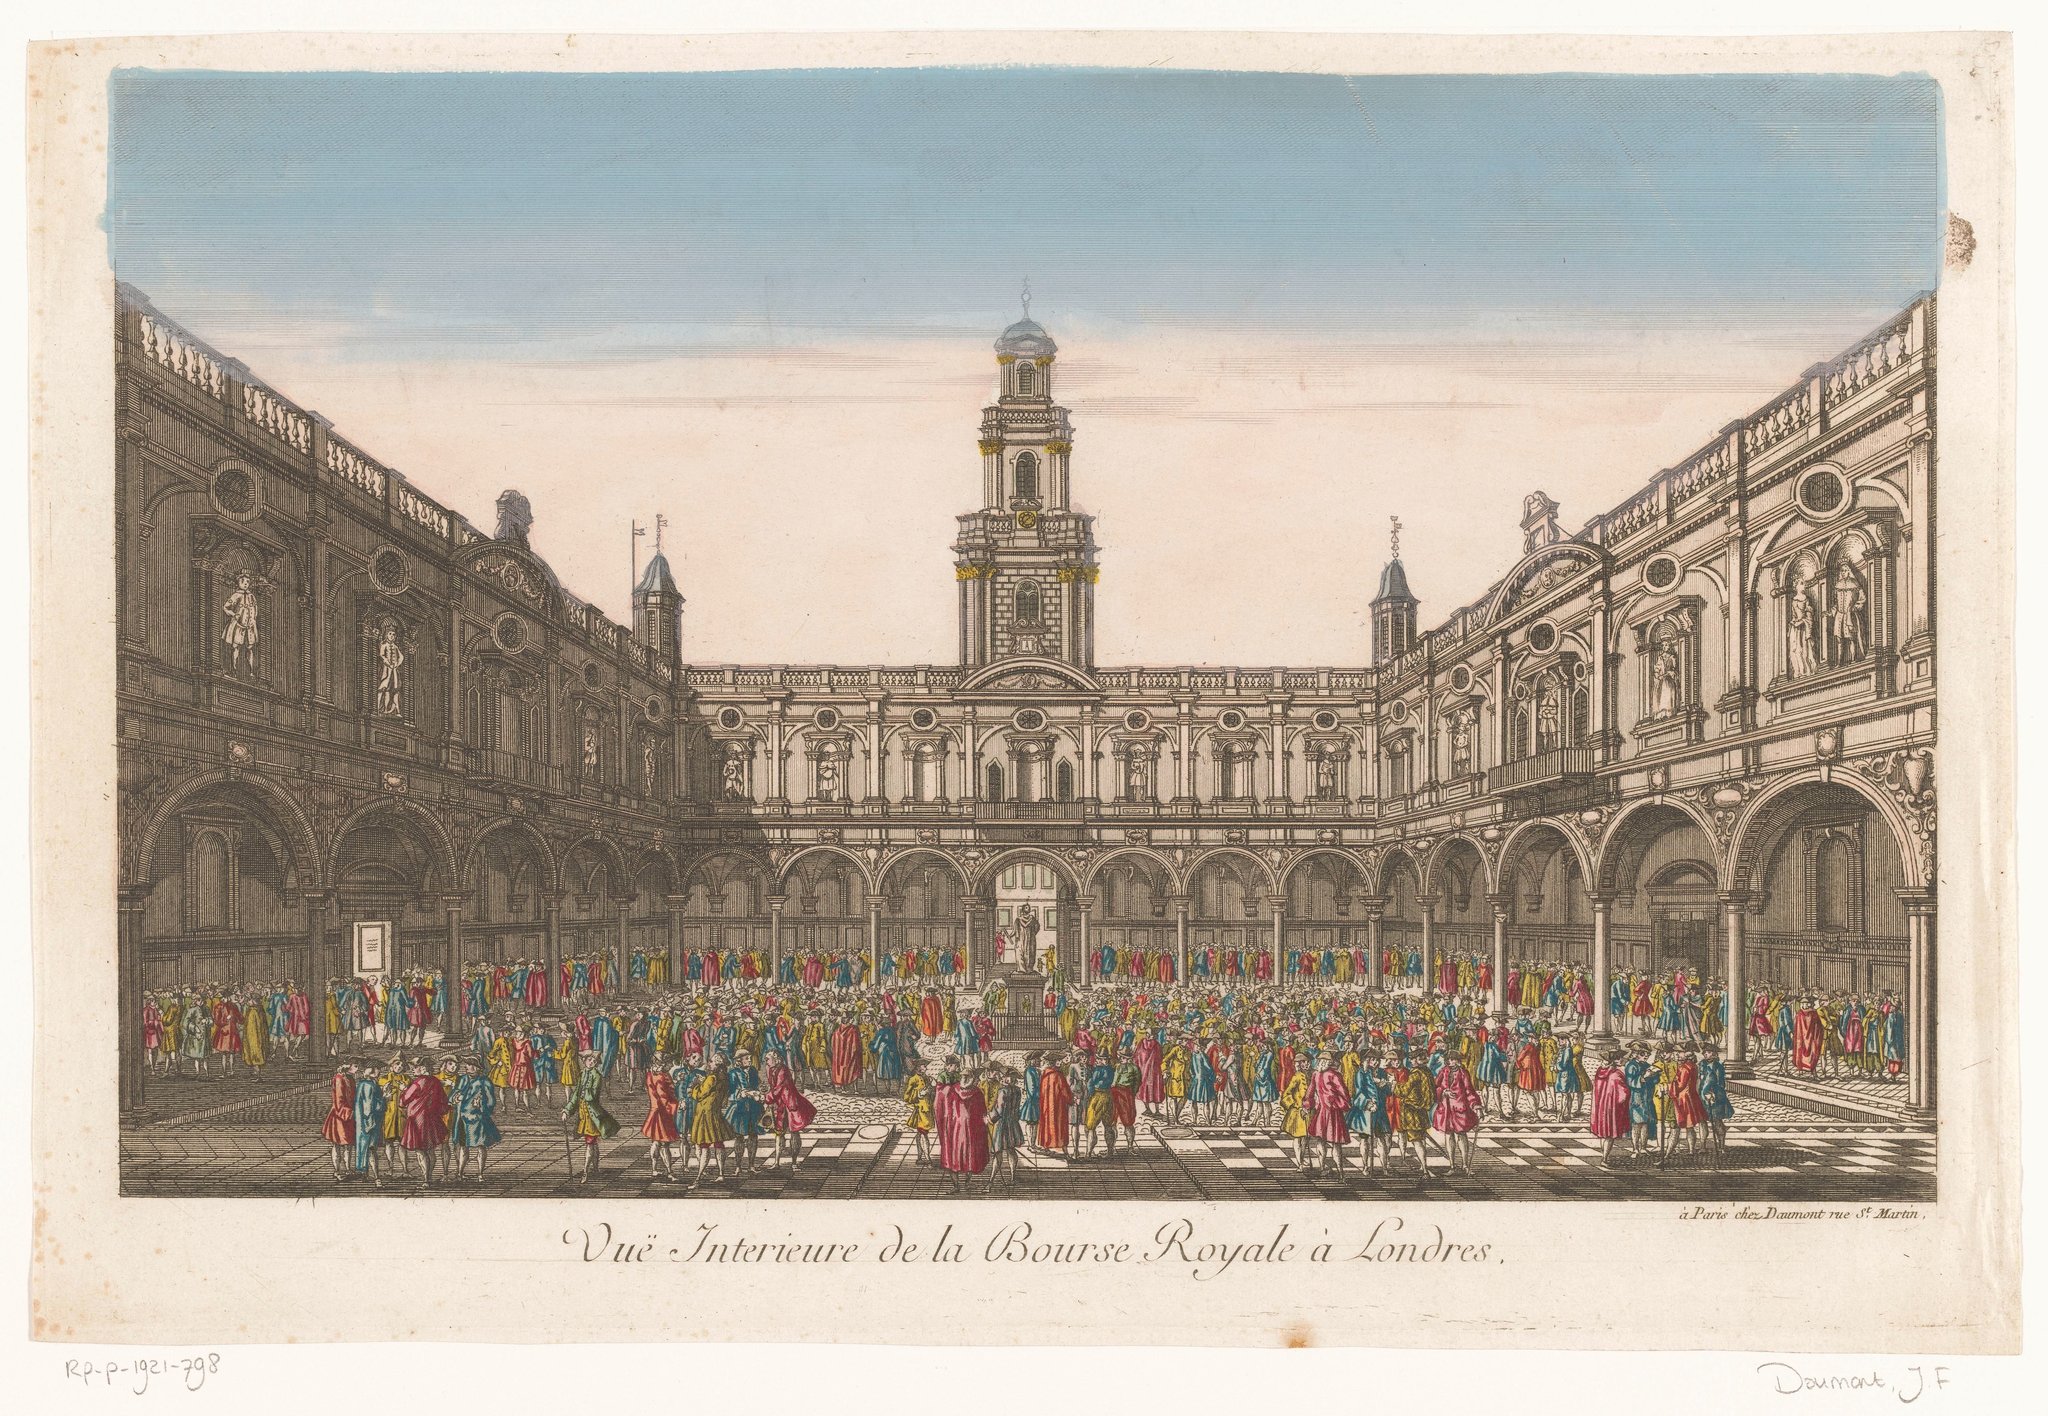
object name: print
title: Gezicht op het interieur van de Royal Exchange te Londen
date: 1745-1775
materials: paper, watercolor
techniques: brush, etching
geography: france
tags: stock exchange, stock-market, interior ~ representation of a building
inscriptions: collector's mark: Lugt 2233, watermark